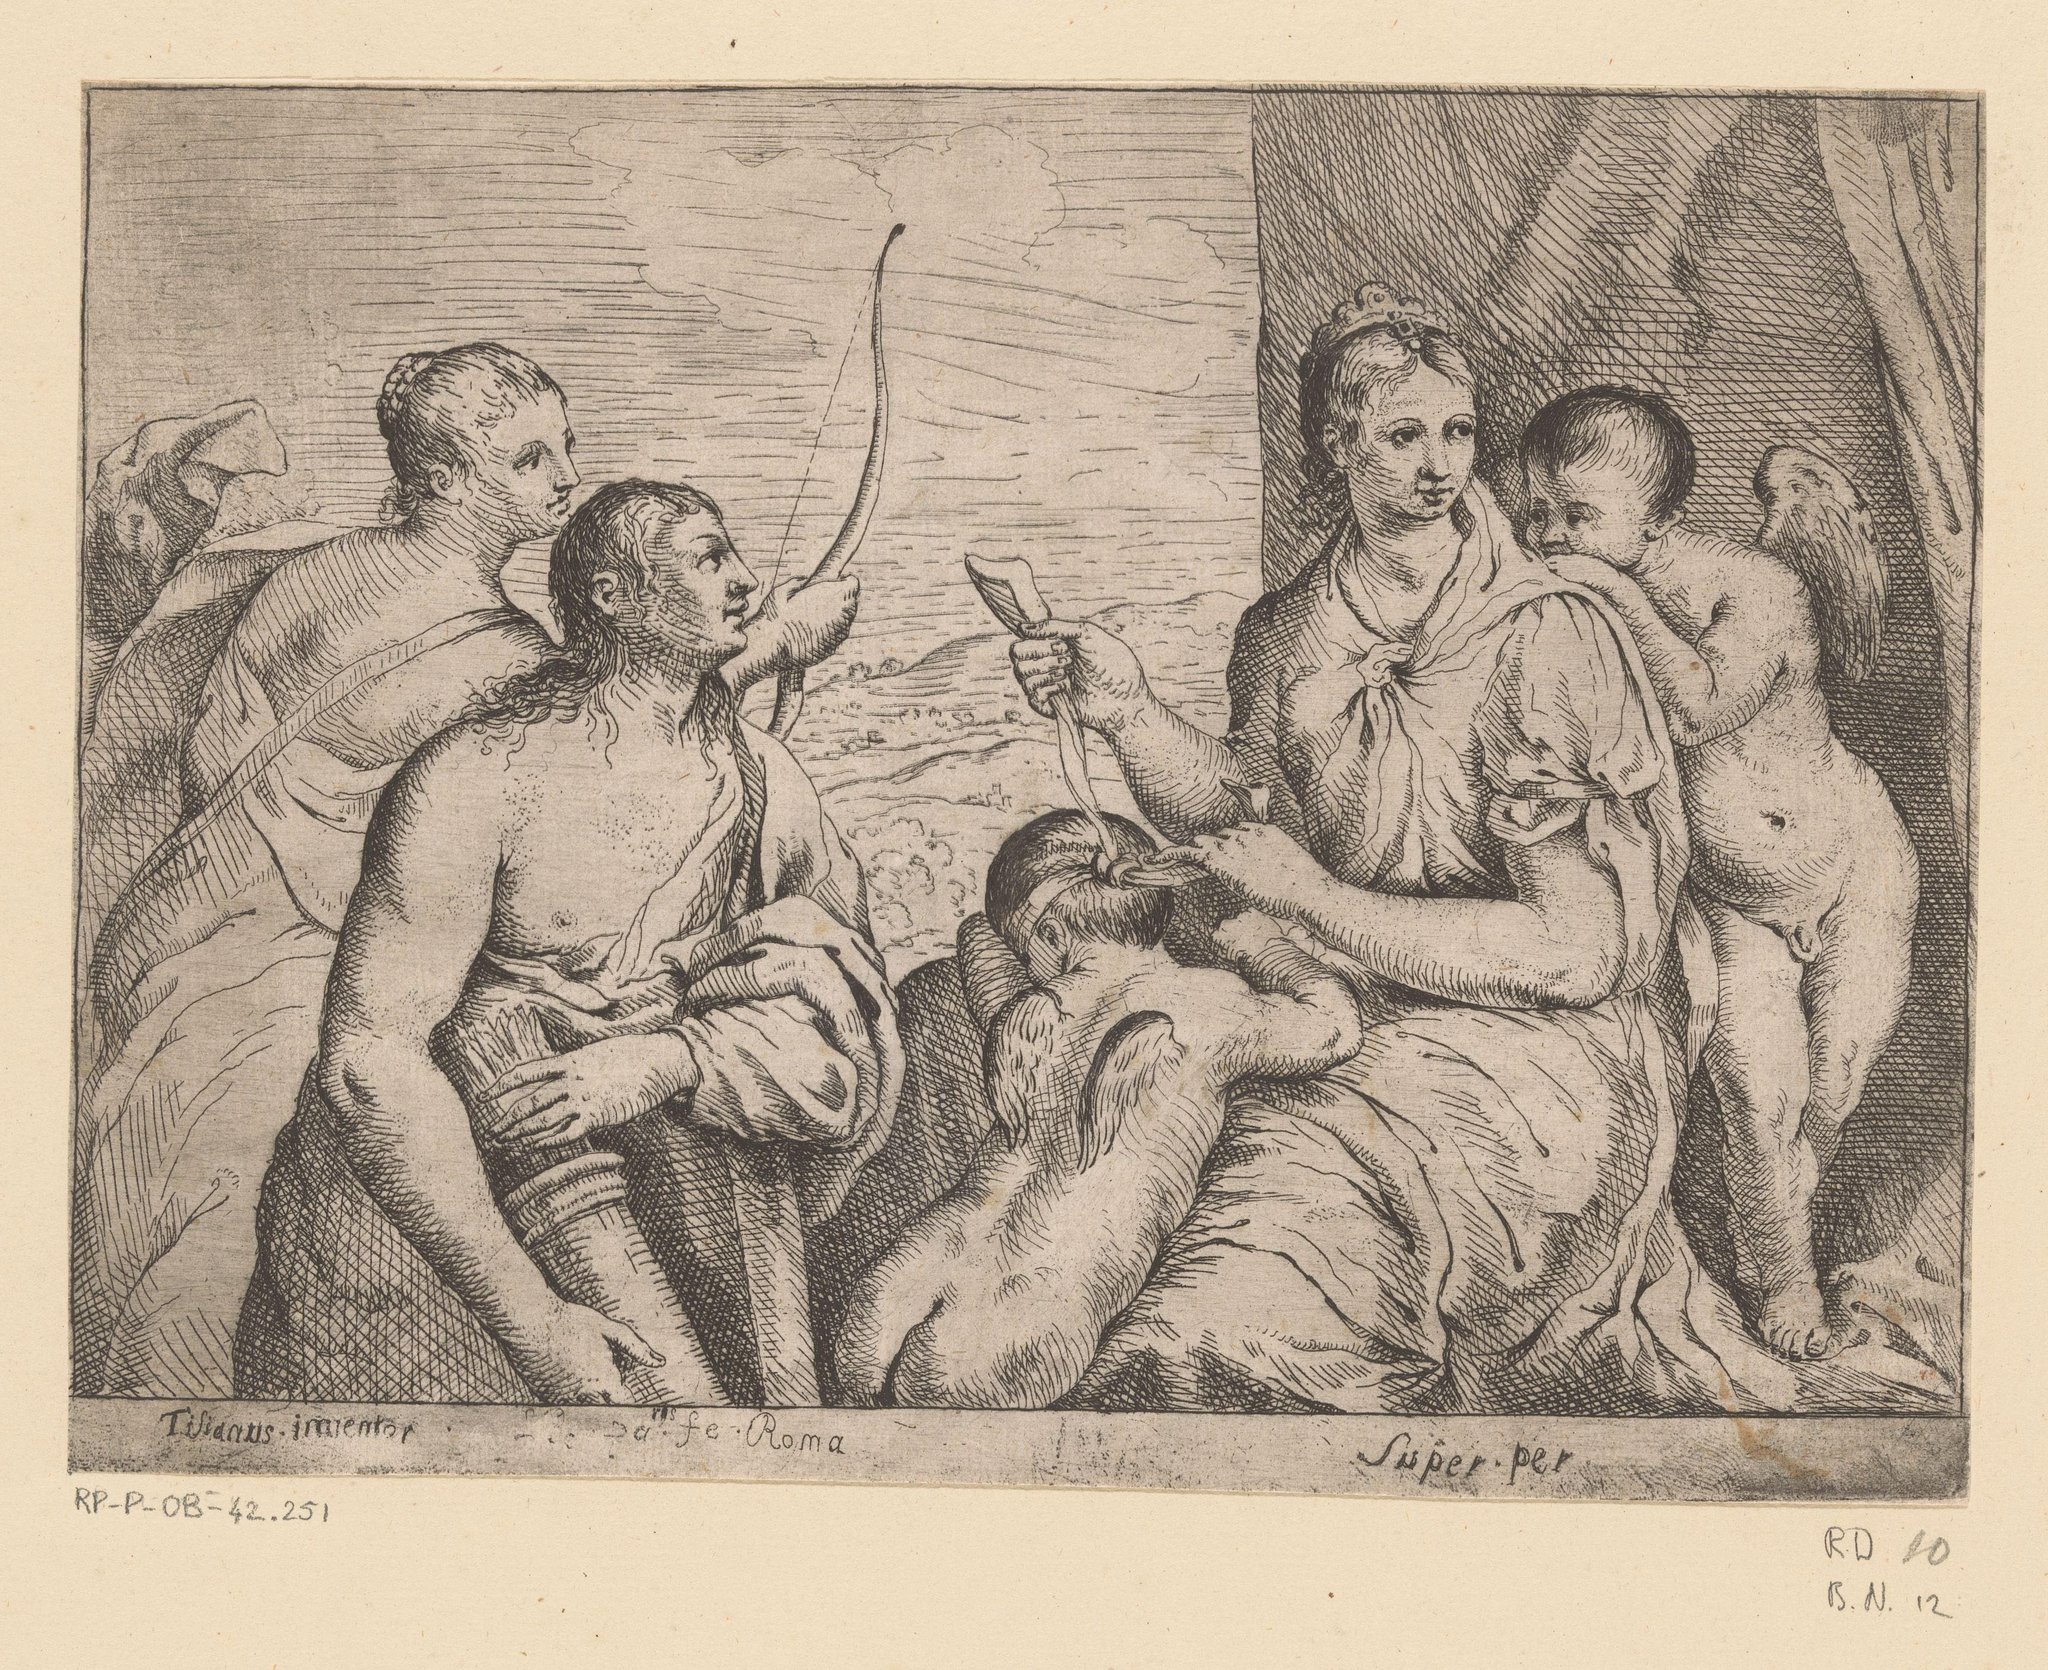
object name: print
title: Venus blinddoekt Amor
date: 1619-1674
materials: paper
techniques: etching, intaglio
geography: rome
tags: blindfold, venus and cupid (cupid not being mere attribute)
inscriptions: collector's mark: Lugt 240